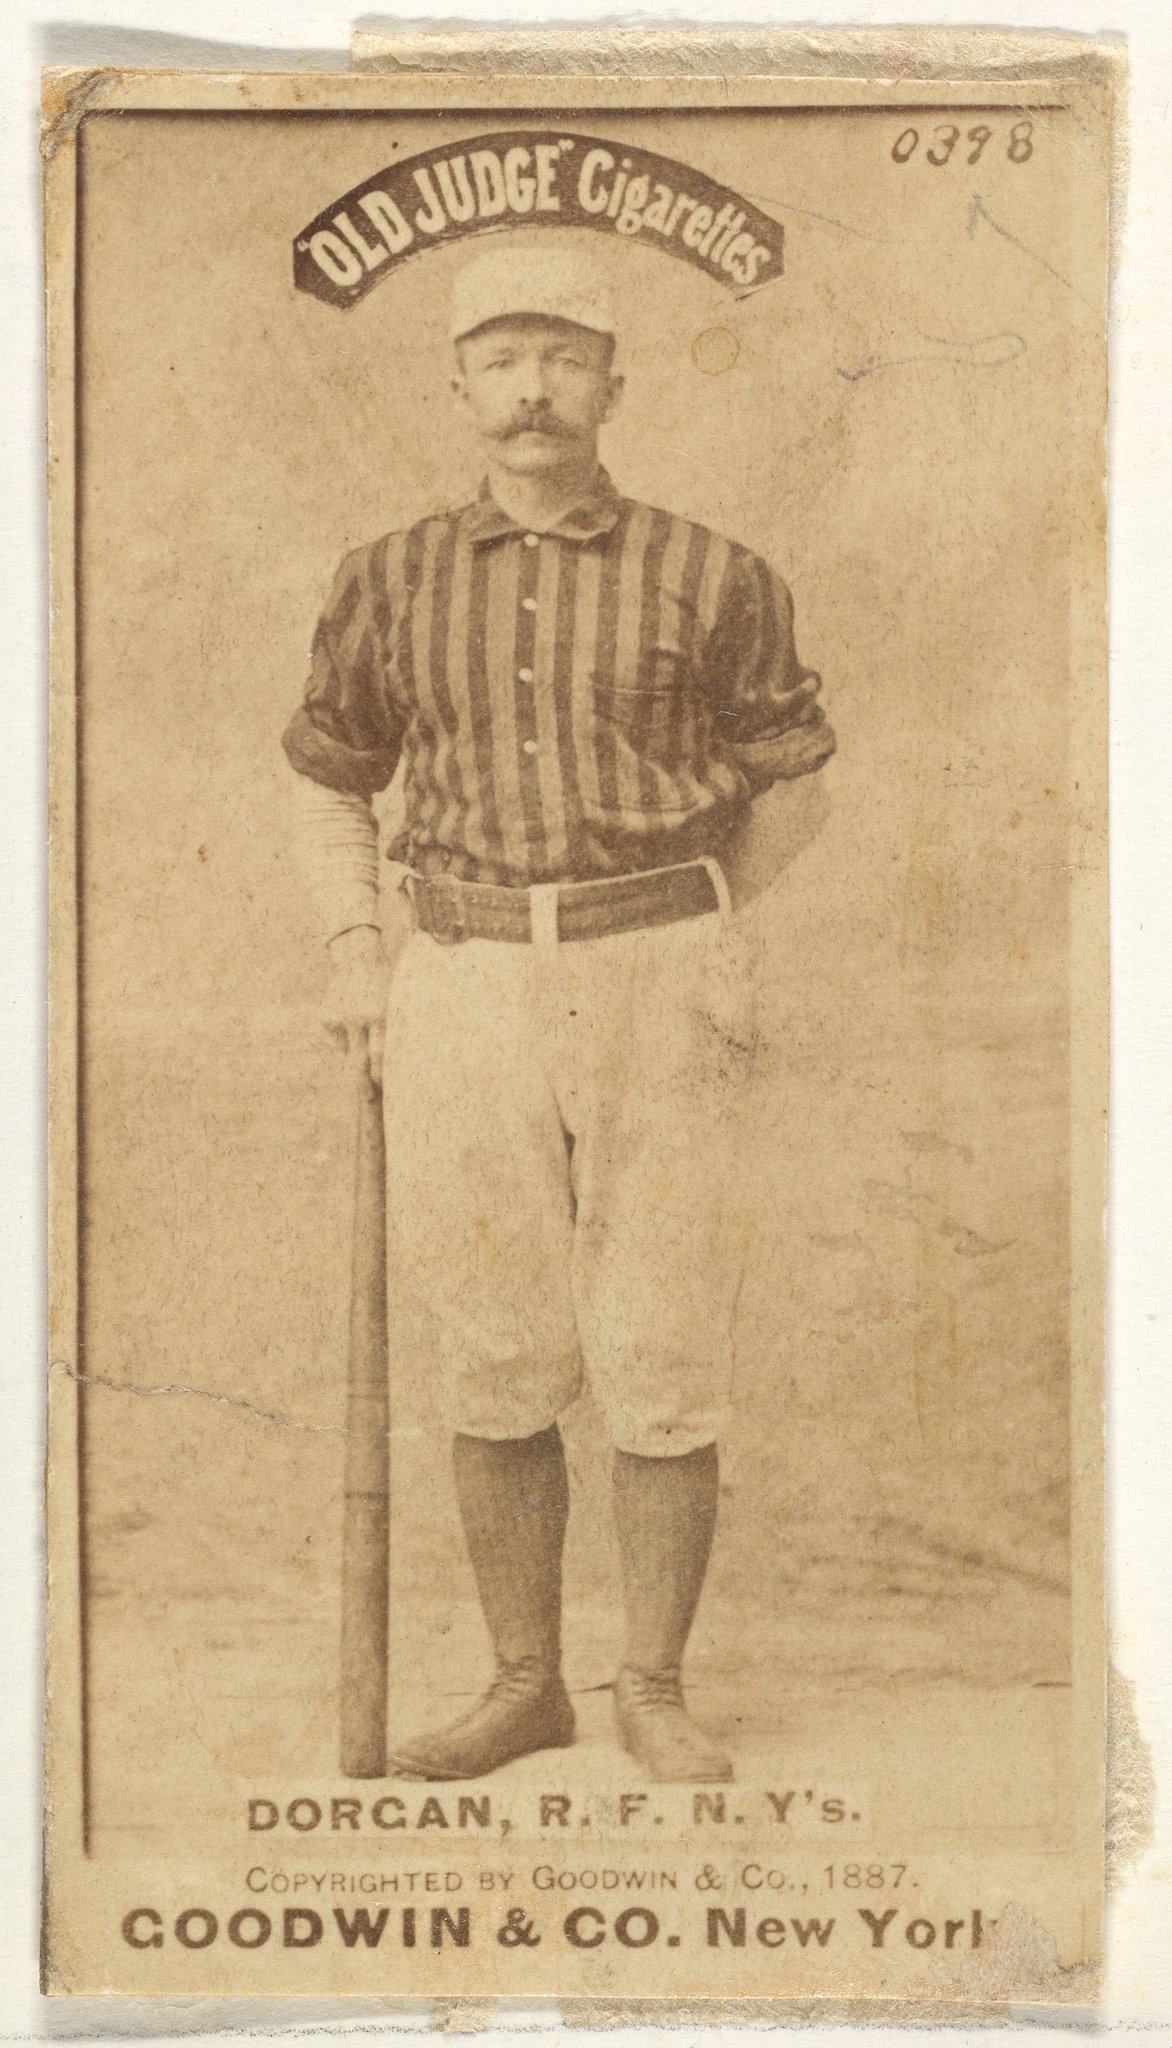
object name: baseball card, photograph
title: Michael Cornelius Dorgan, Right Field, New York, from the Old Judge series (N172) for Old Judge Cigarettes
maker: goodwin & company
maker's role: publisher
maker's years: 1850-1950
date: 1887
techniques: albumen silver print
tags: men,portraits,baseball,athletes